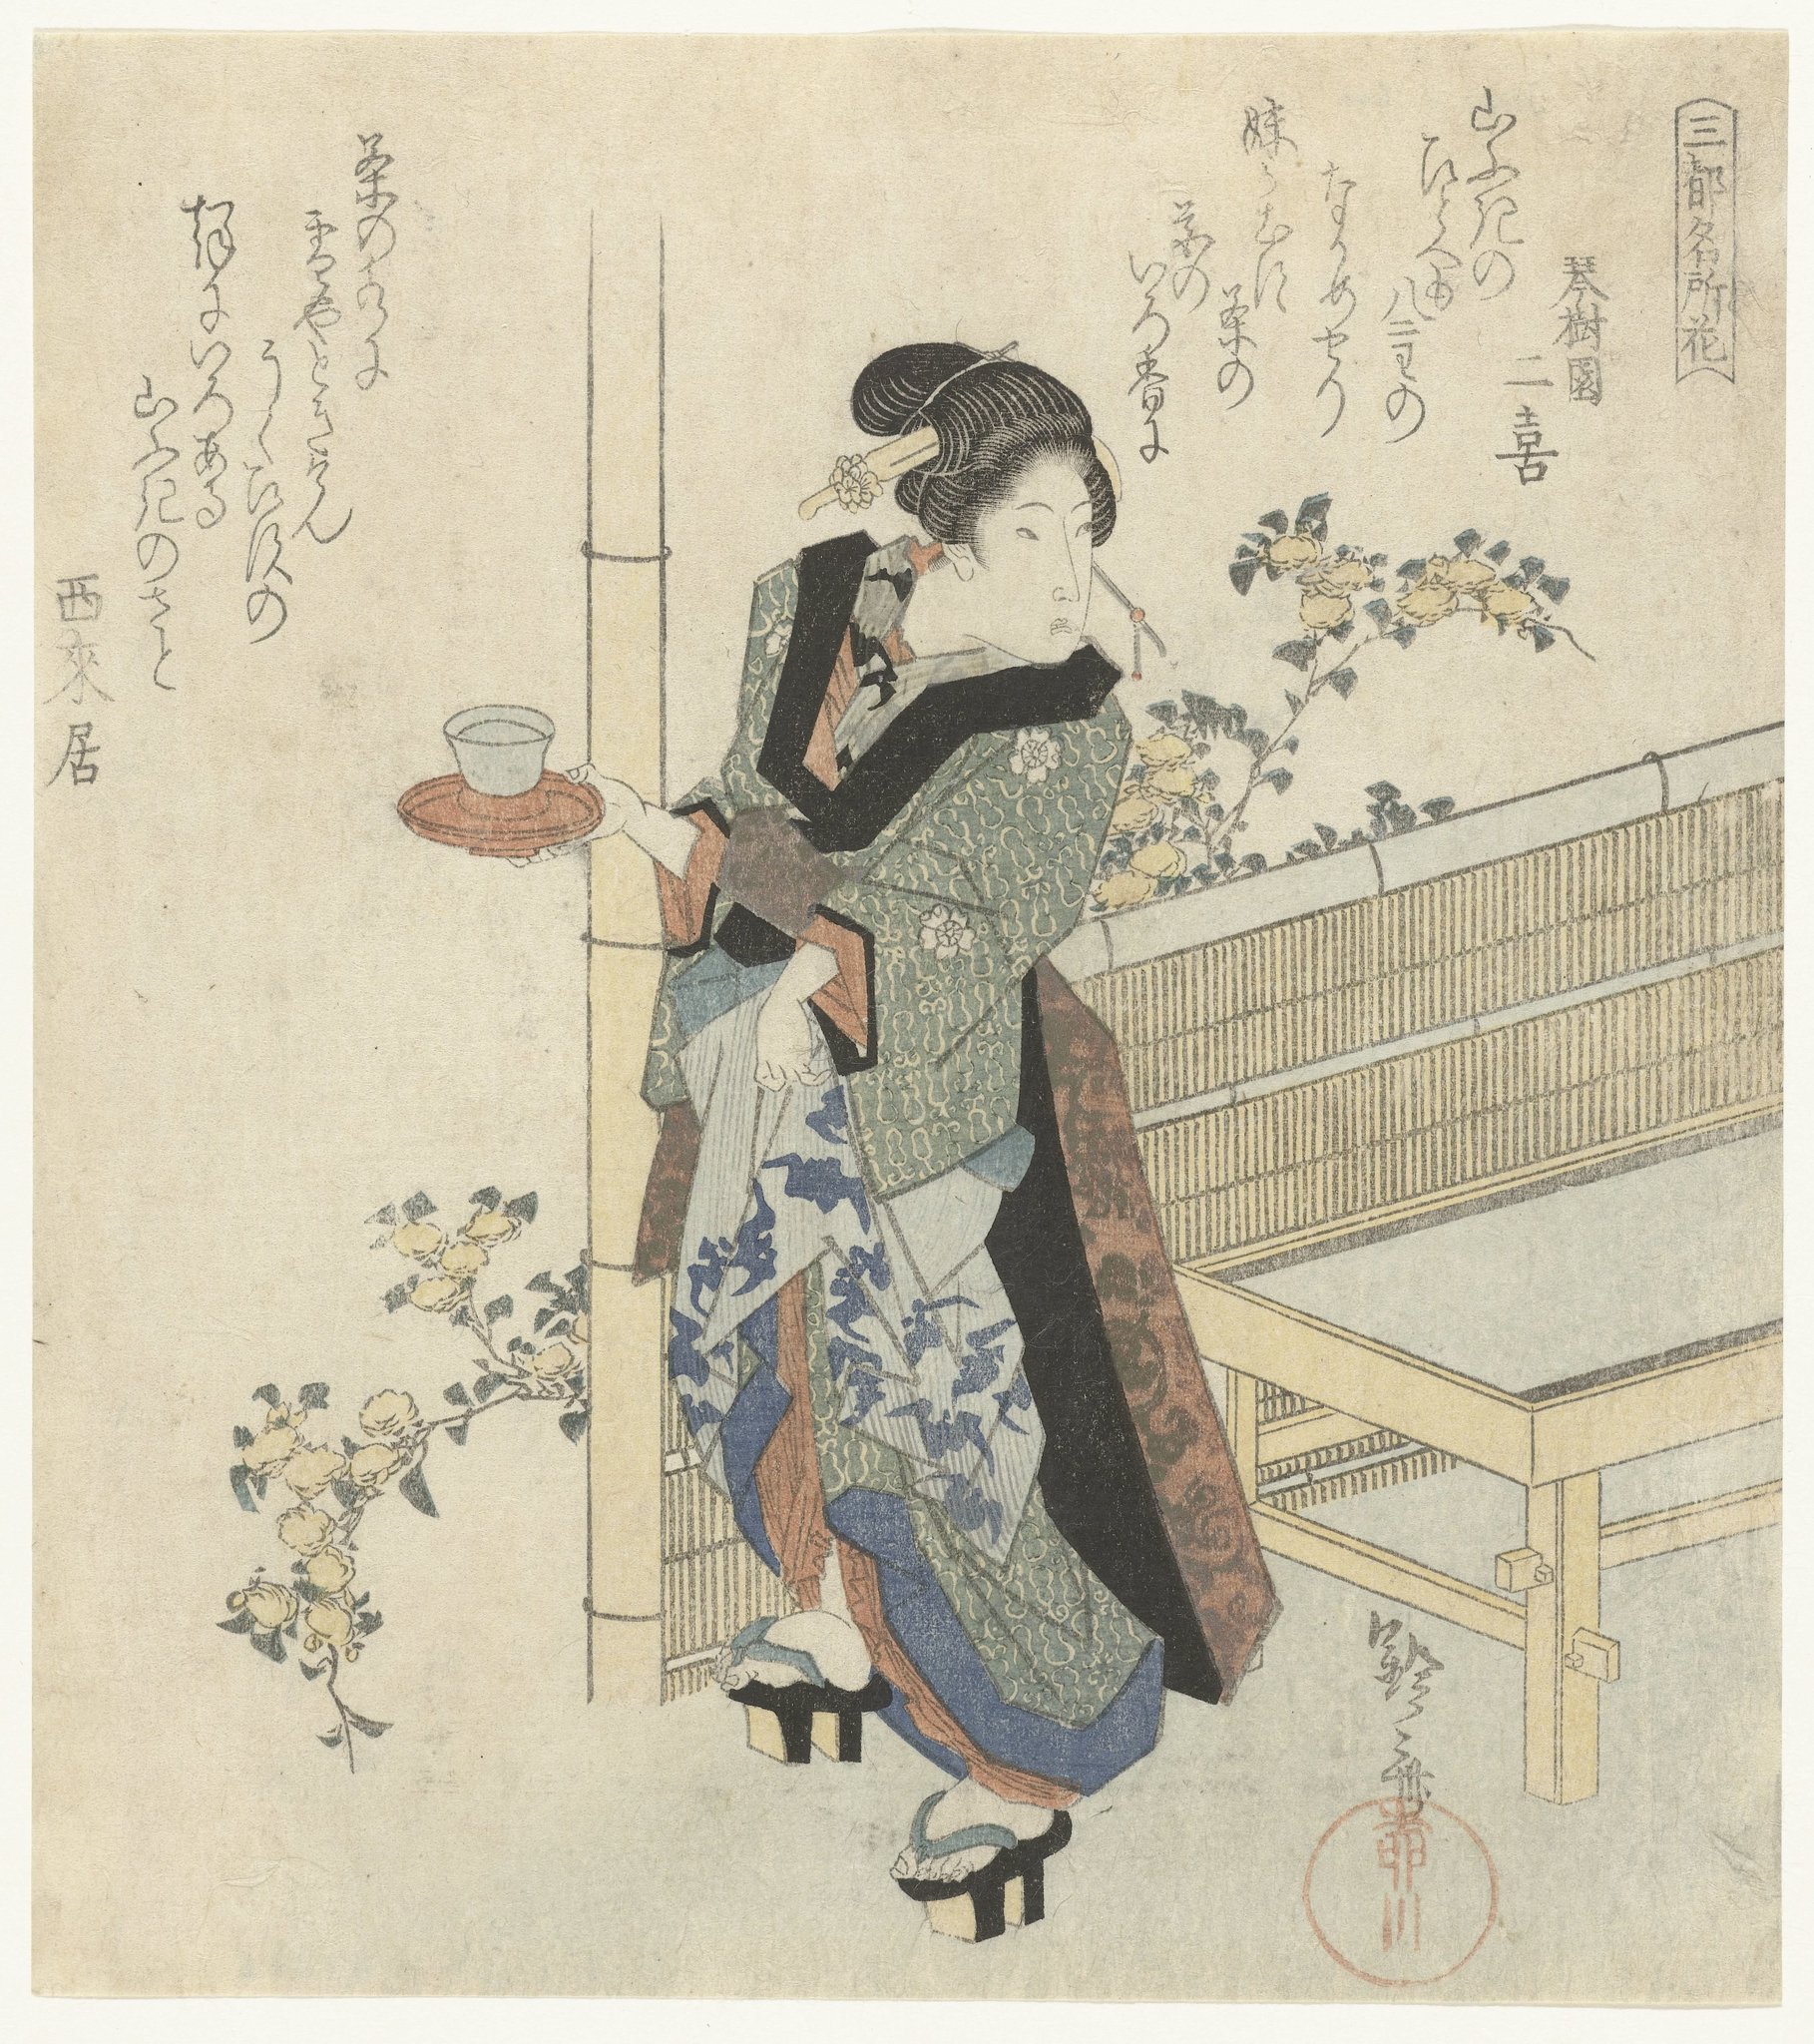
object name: print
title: Serveerster bij Yamabuki bloemen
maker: yanagawa shigenobu (i)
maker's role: draughtsman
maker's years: 1787-1832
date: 1827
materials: paper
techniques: woodcut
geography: japan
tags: indoor recreation (+ waiter, waitress, etc.), tea garden, garden restaurant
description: Serveerster van een theehuis, met in rechter hand een dienblad met kopje, staand bij tafel en bamboe hek, waarachter een struik met gele Yamabuki bloemen. Gedicht linksboven door de dichter Sairaikyo; gedicht rechtsboven door de dichter Kinjuen Futaki.